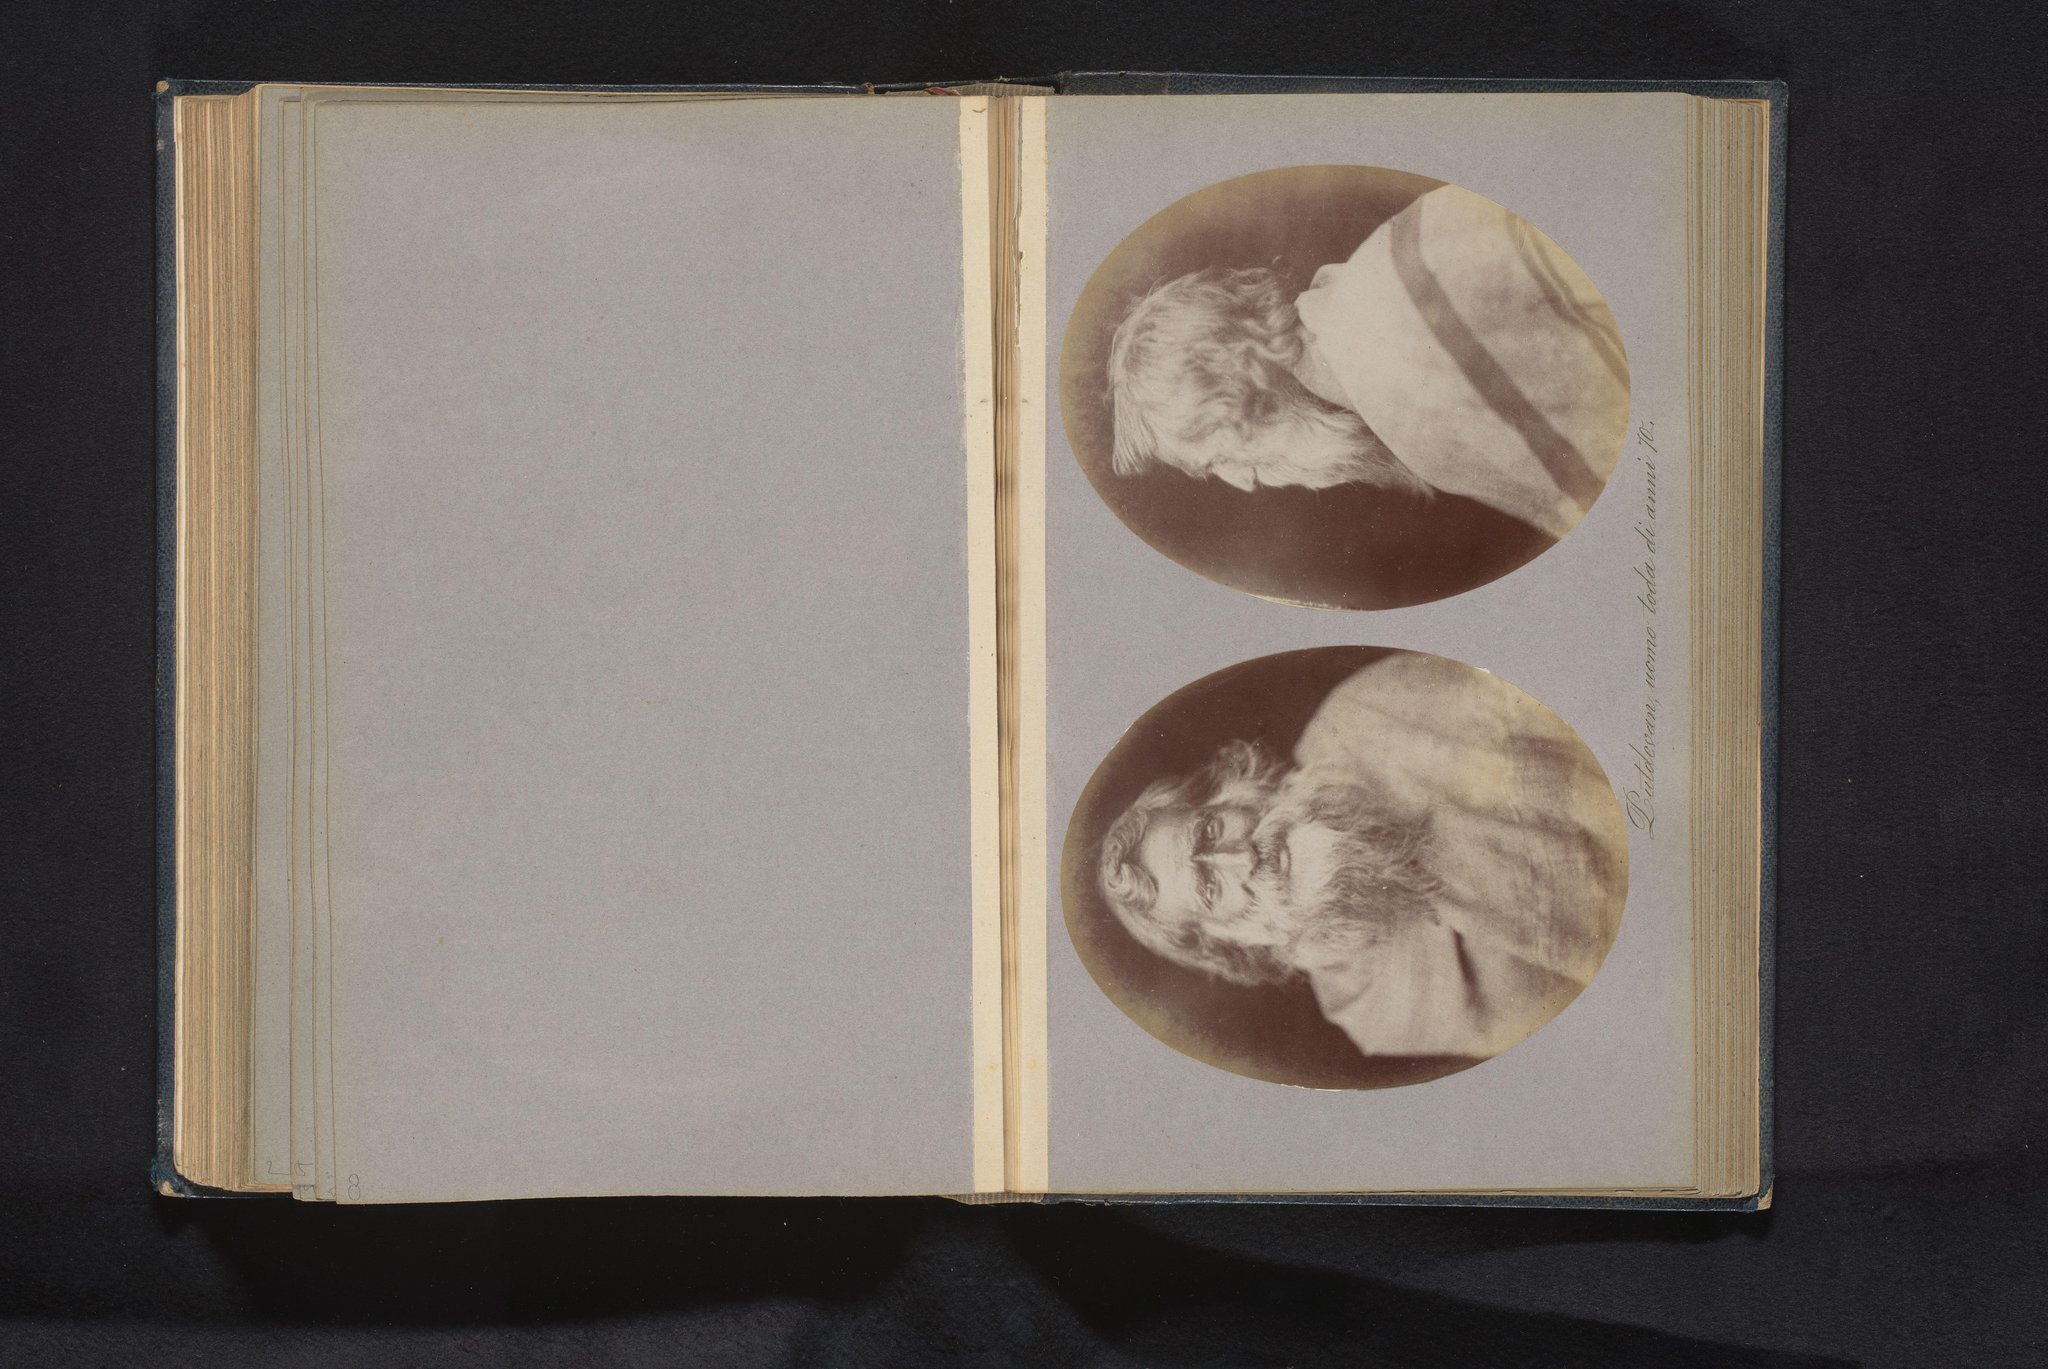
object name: page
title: Lutdevan, uomo toda di anni 70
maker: paolo mantegazza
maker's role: antropoloog, professor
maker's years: 1831-1910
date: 1881-1886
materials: photographic support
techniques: albumen print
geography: india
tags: adult man (+ front view), adult man (+ sideview, profile)